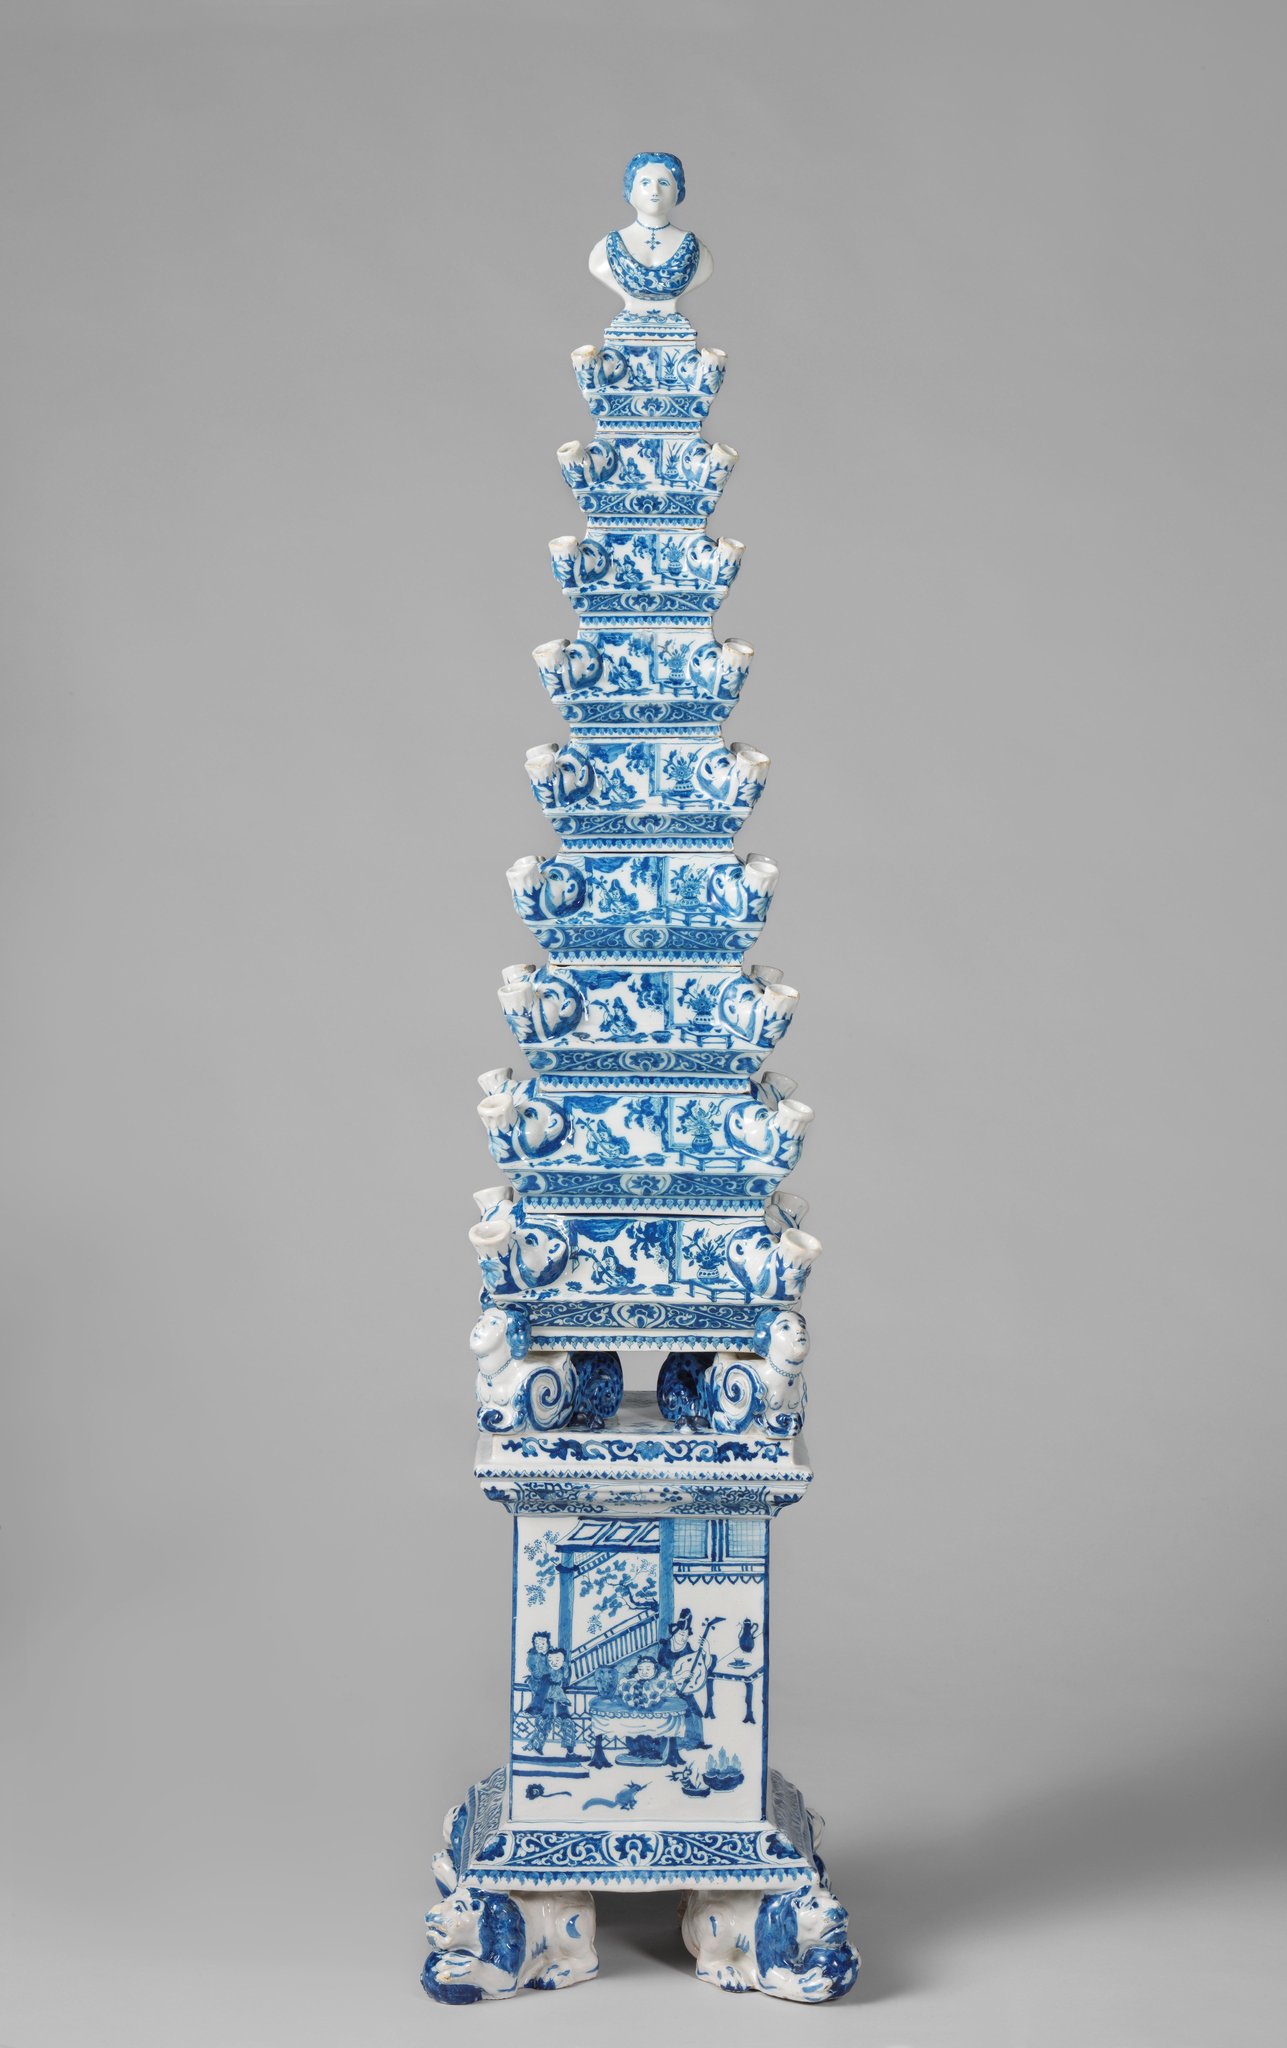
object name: bloempiramide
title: Flower pyramid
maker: lambertus van eenhoorn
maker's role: plateelbakker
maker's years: 1651-1721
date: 1692-1700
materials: earthenware, glaze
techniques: painted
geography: delft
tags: flowers, one person playing string instrument (plucked), beasts of prey, predatory animals: lion, chest, bust - aa - female human figure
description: Segment van bloempiramide van faience, blauw beschilderd in de glazuur. Musicerende figuren en figuren met schaal.